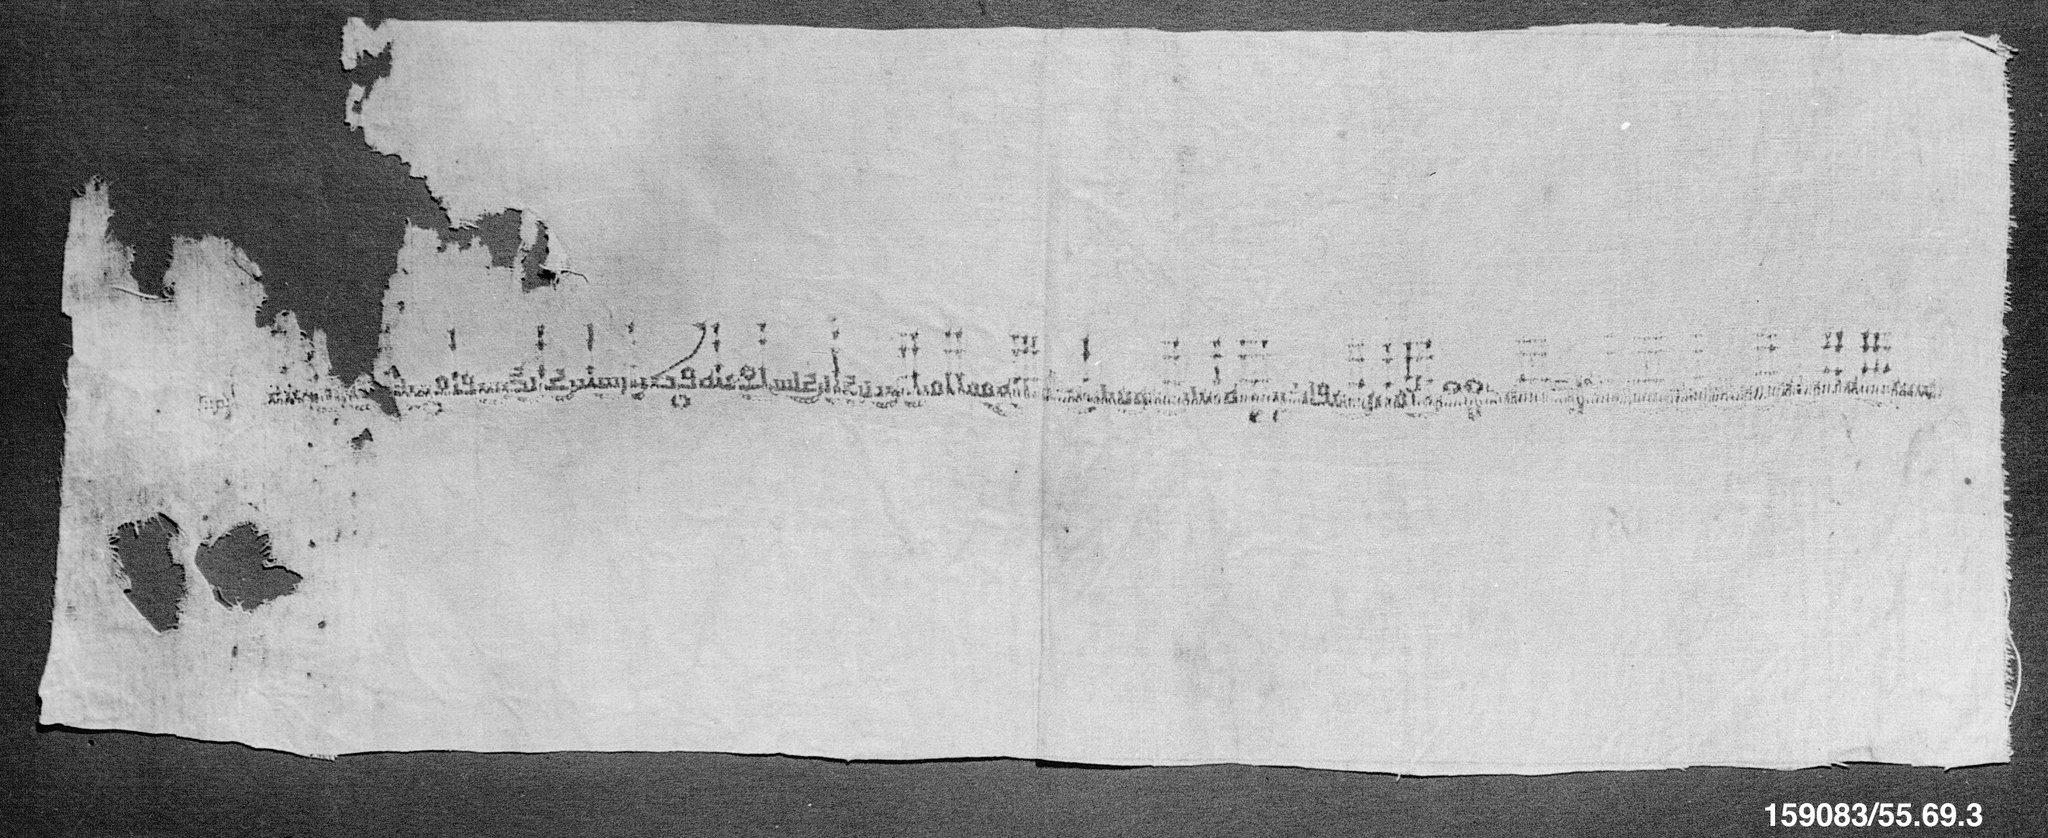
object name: textile fragment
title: Tiraz Fragment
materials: linen, silk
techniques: embroidery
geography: egypt